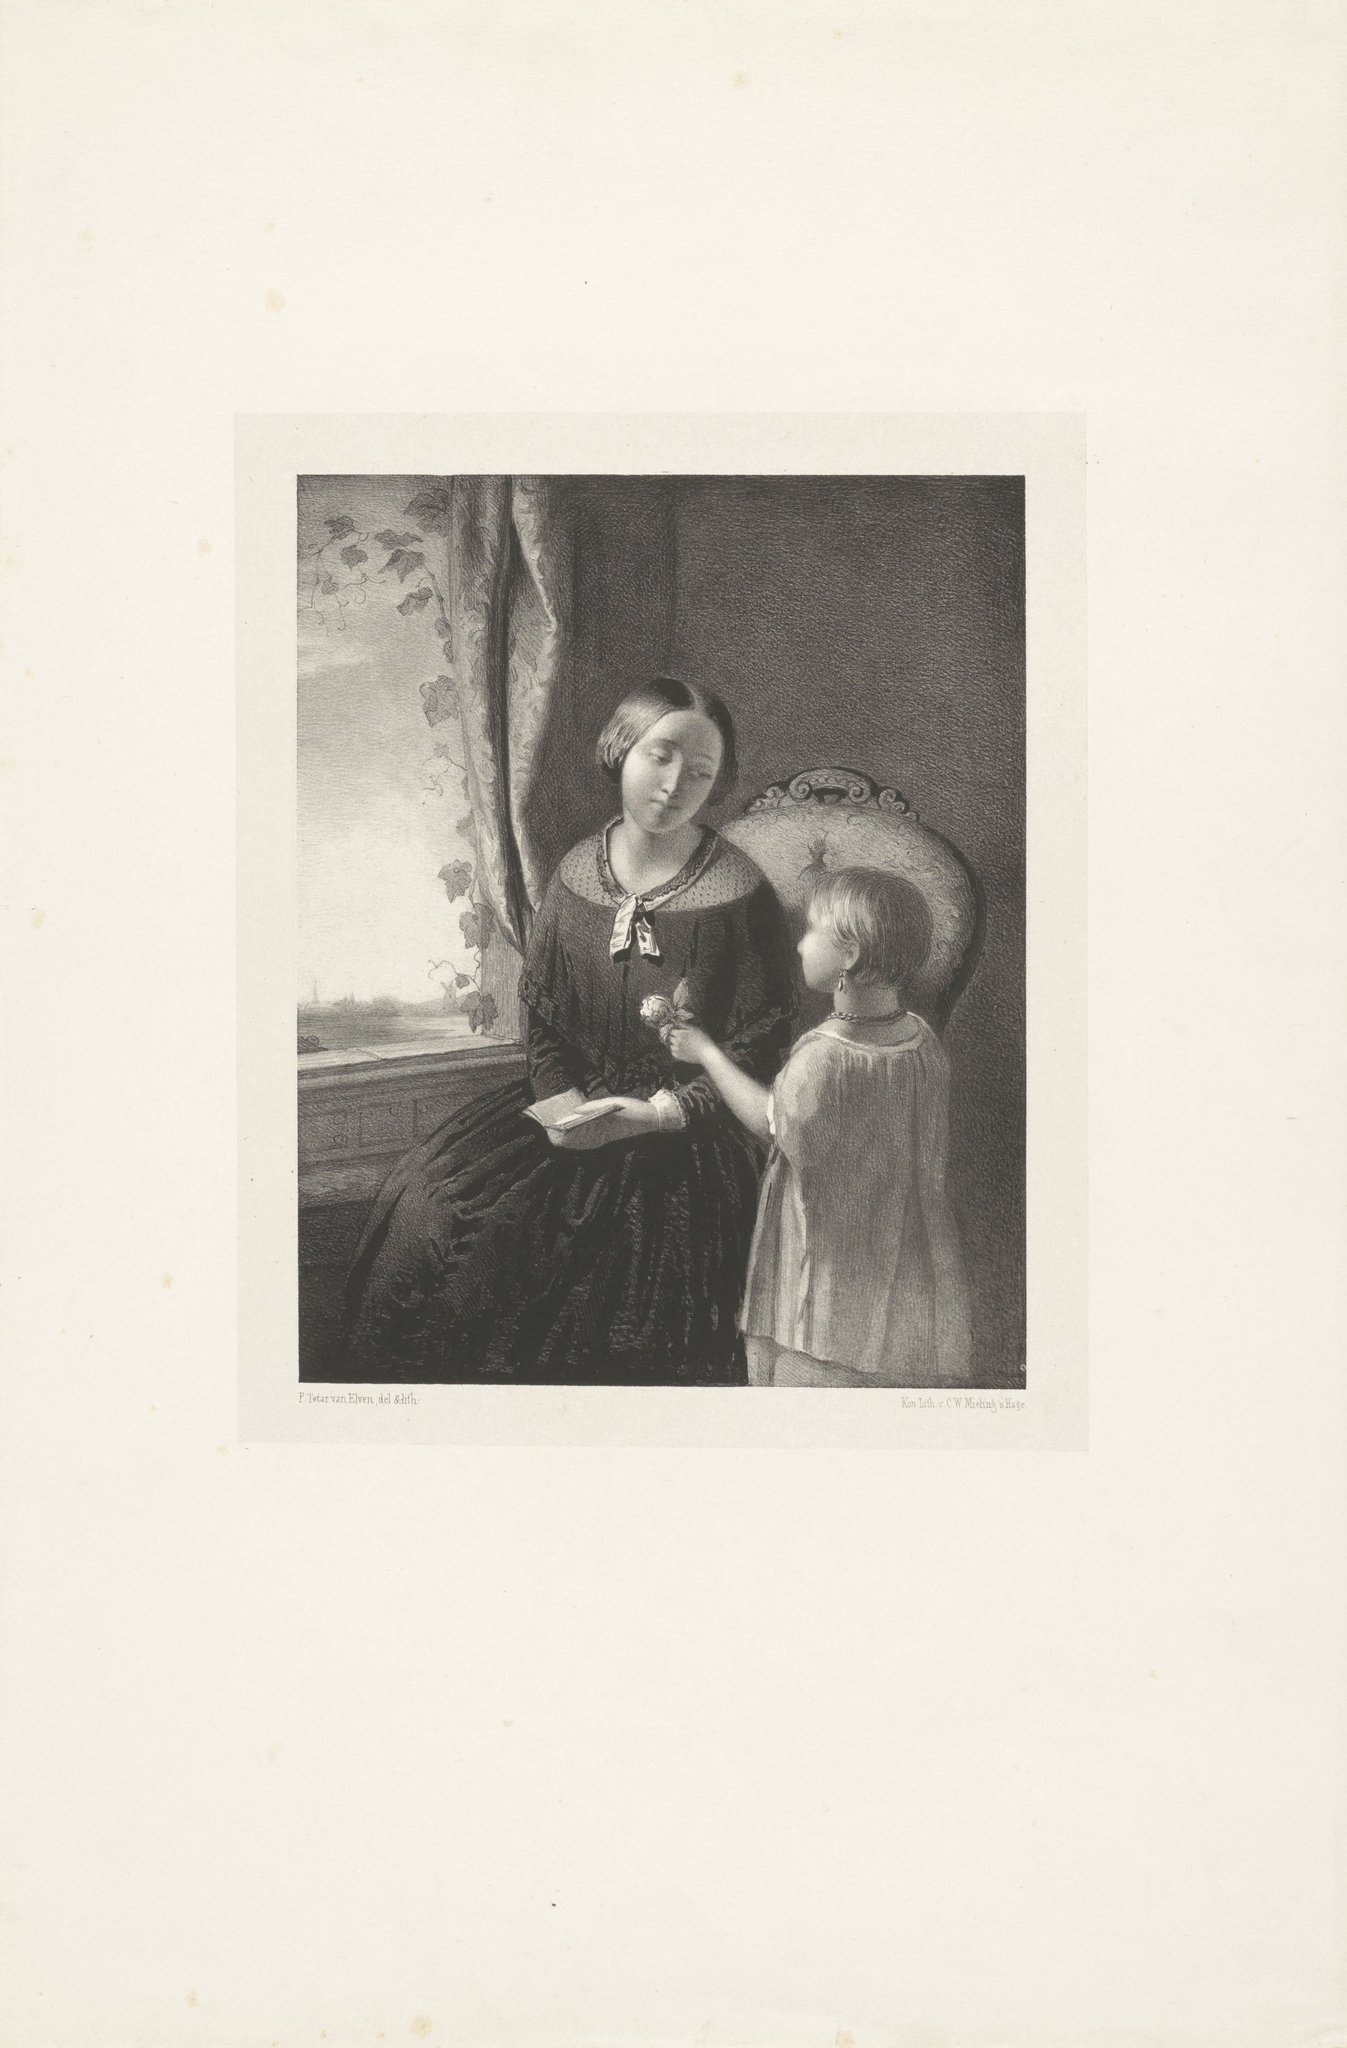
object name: print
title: Vrouw met kind bij een raam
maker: paul tetar van elven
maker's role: print maker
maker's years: 1823-1896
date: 1833-1896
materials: paper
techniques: lithograph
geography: the hague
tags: flowers, mother and baby or young child, open window, plants and herbs: ivy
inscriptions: collector's mark: Lugt 2228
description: Het meisje biedt de vrouw een bloem aan. Ze draagt een ketting en oorbellen. De vrouw heeft een opengeslagen boek in haar handen. Langs het raam groeit klimop.